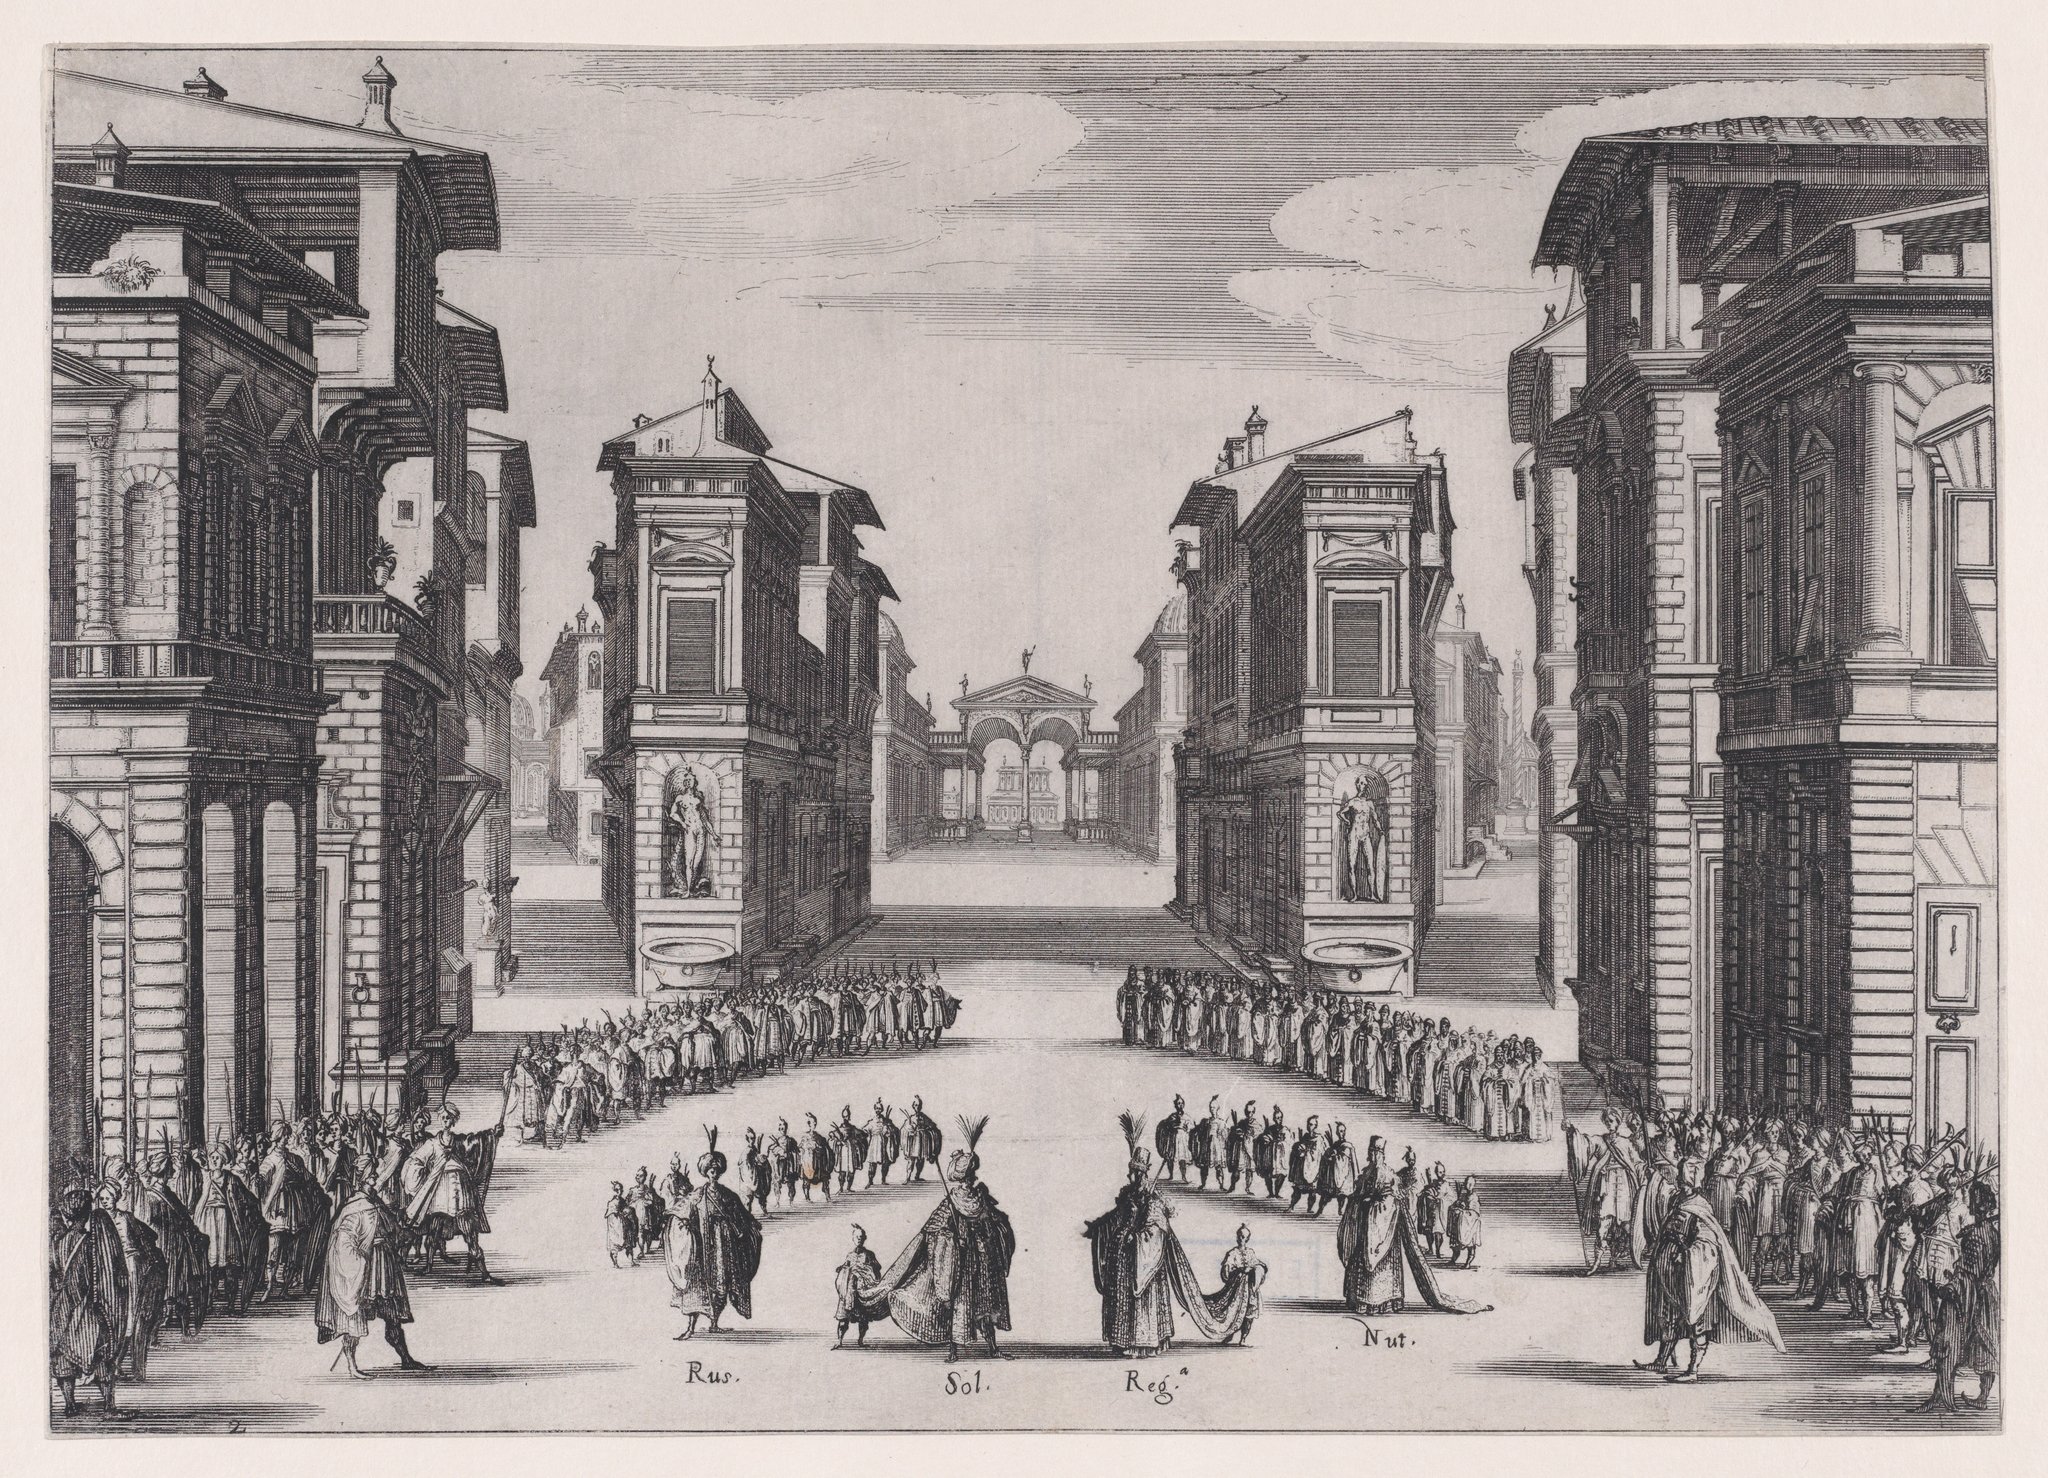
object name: print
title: Soliman 2.e Acte, from "Soliman"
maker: jacques callot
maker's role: artist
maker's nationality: french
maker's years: 1592-1635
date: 1620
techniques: engraving, etching